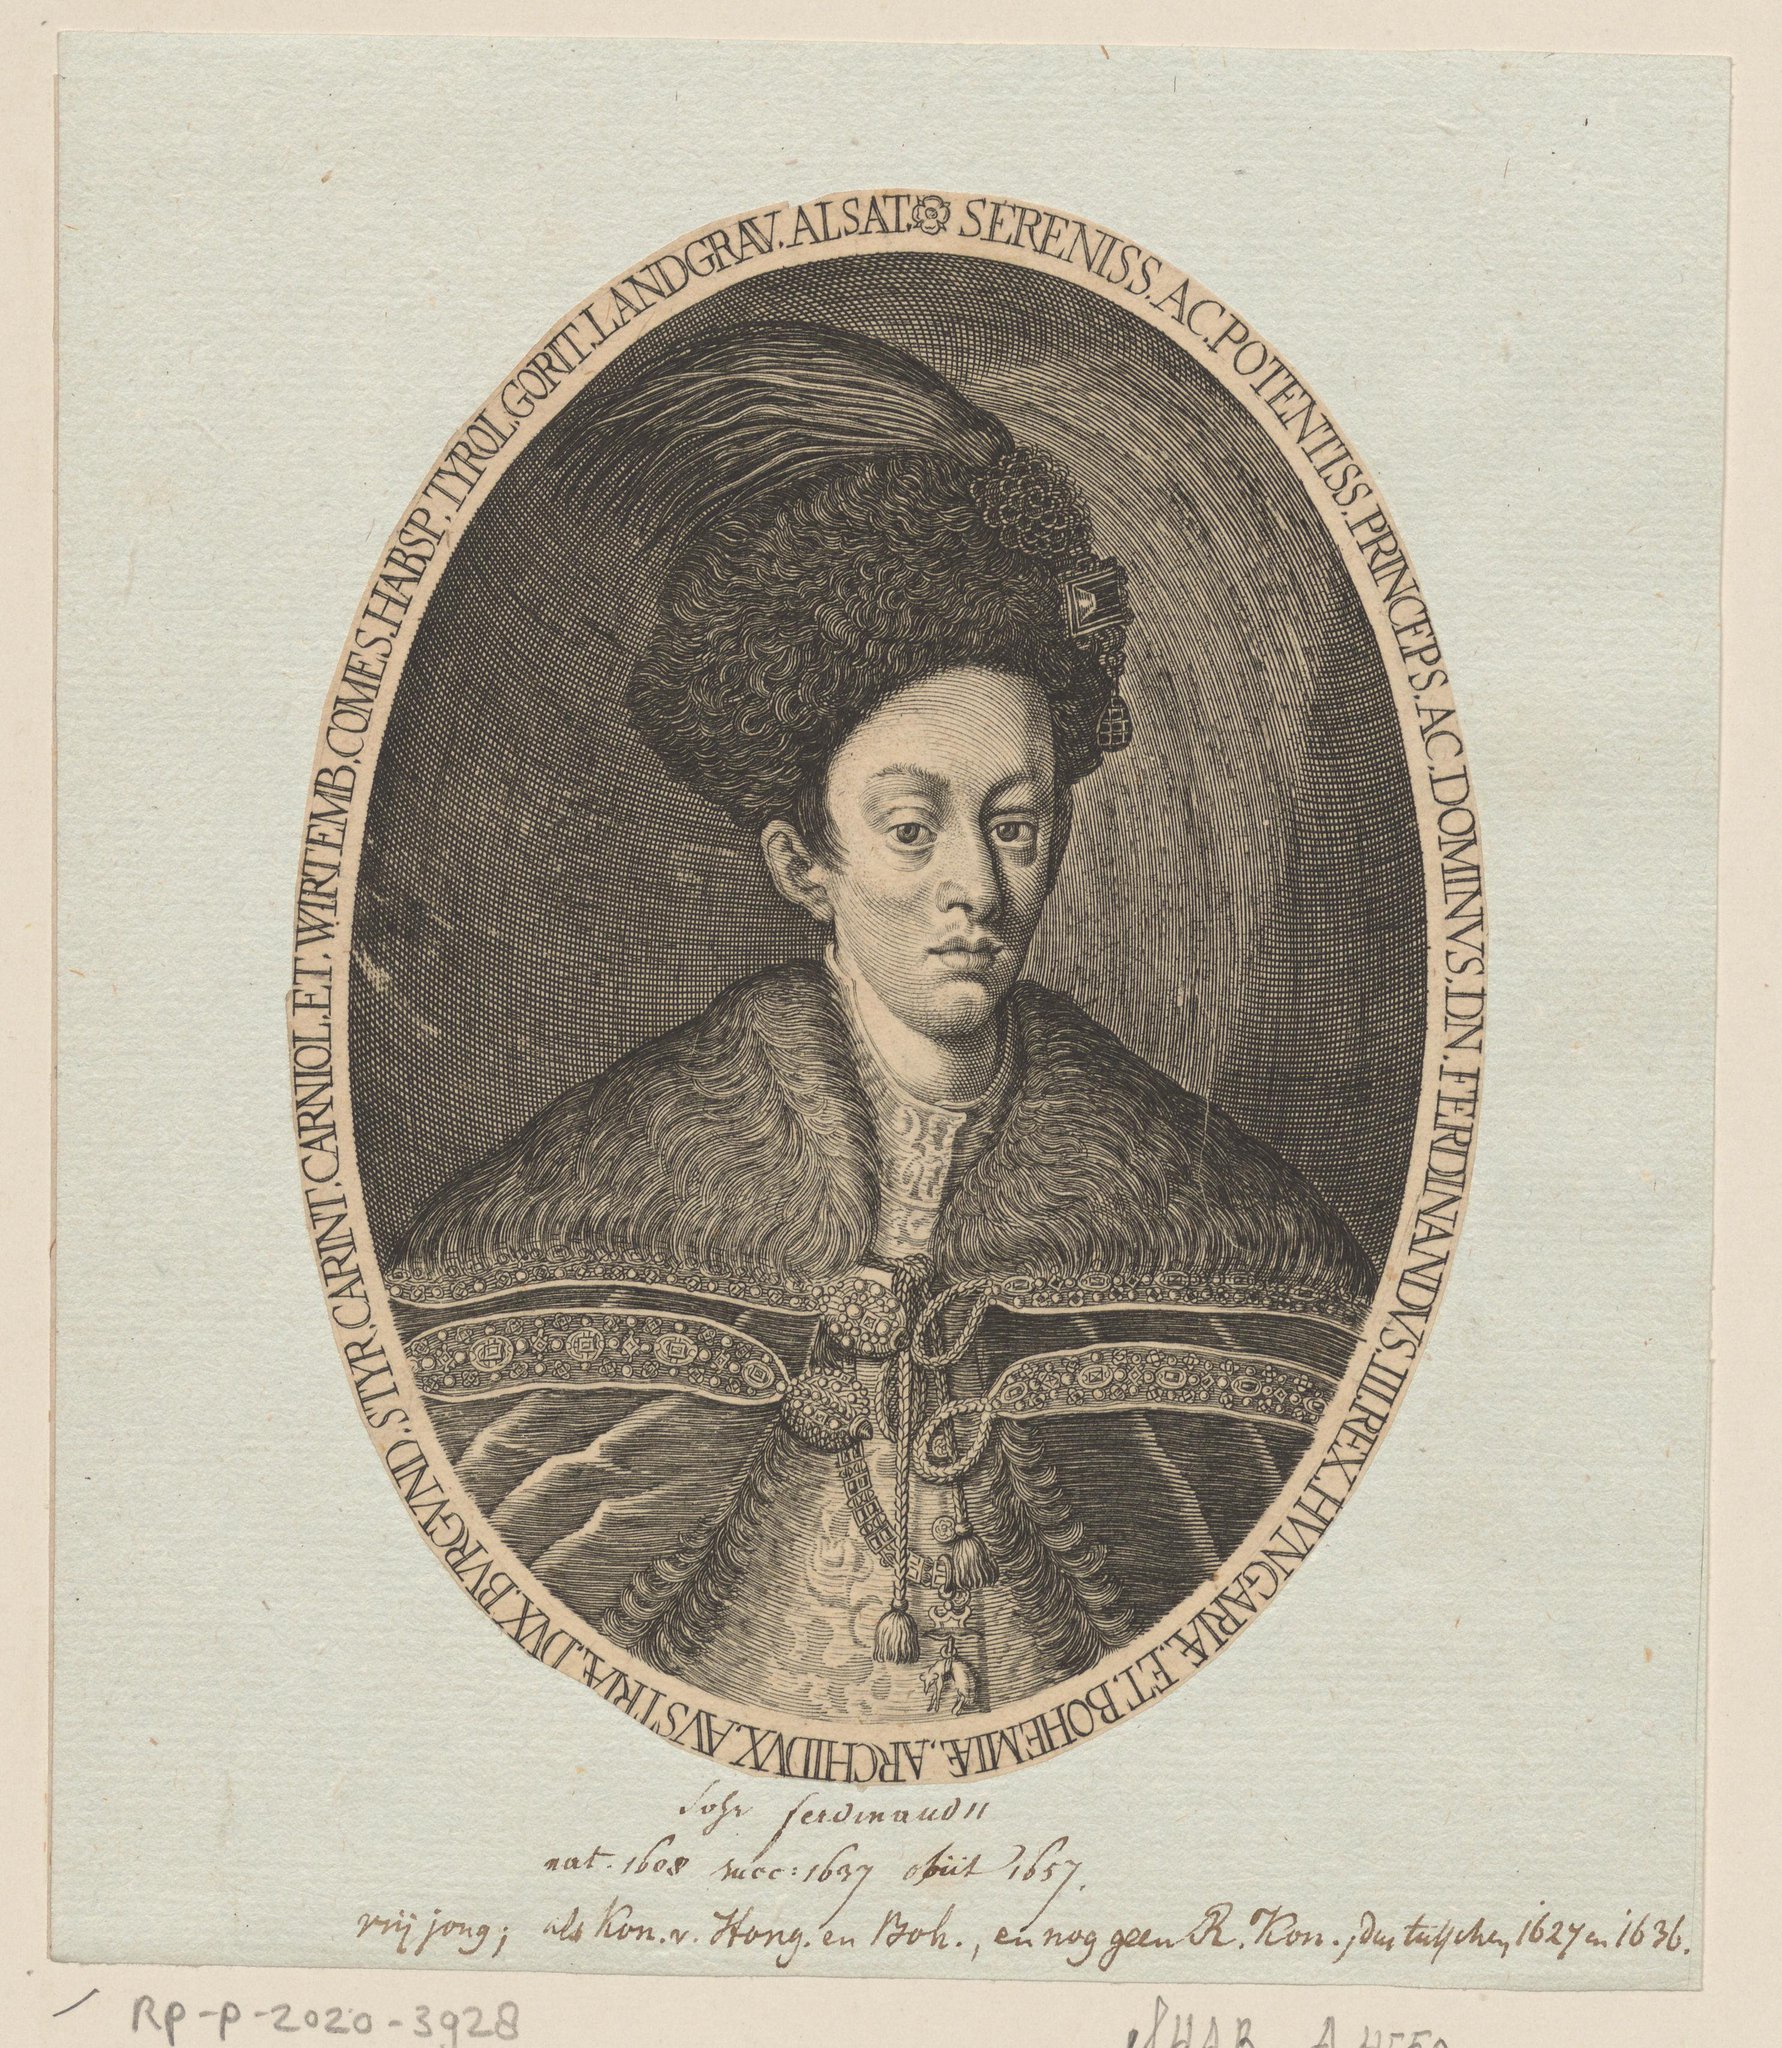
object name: print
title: Portret van keizer Ferdinand III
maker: wolfgang kilian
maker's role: print maker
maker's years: 1581-1662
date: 1627-1637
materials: paper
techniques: engraving, etching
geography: germany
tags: ferdinand iii (duits keizer), historical persons, knighthood order of the golden fleece, emperor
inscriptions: inscription: ‘Sohn Ferdinand II/ nat. 1608 succ: 1637 obiit 1657./ vrij jong; als Kon. v. Hong. en Boh., en nog geen R. Kon., dus tusschen 1627 en 1636’